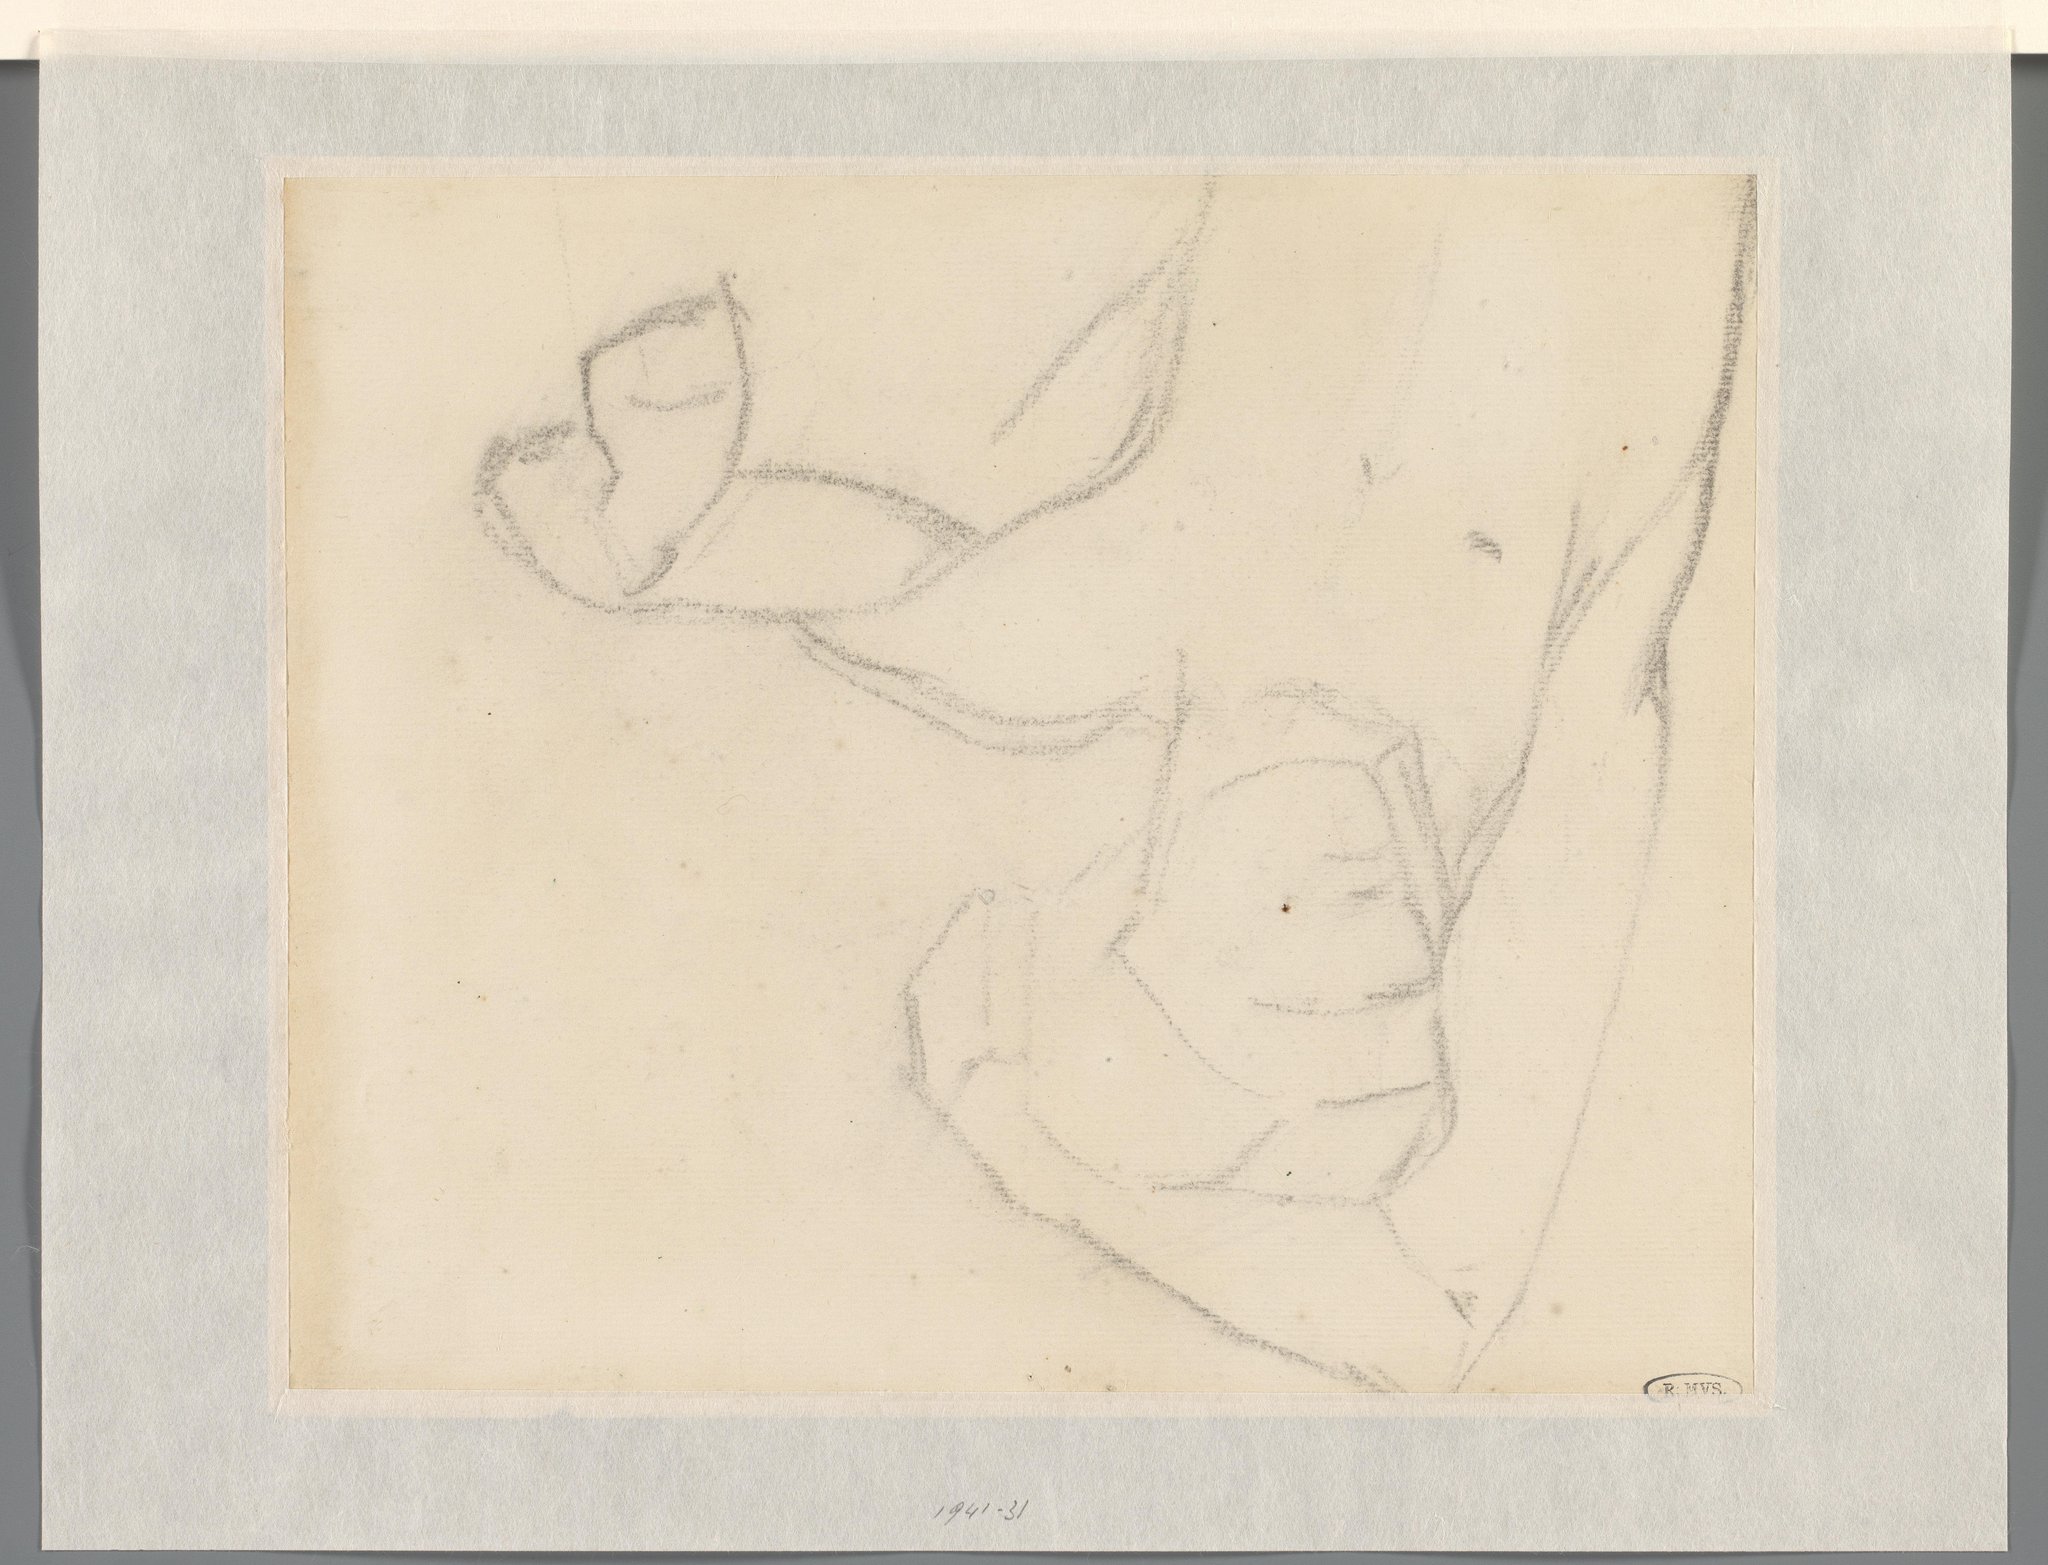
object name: drawing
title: Studie van een staand mannelijk naakt, ten halven lijve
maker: piet meiners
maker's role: draughtsman, painter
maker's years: 1857-1903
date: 1867-1903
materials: chalk, paper